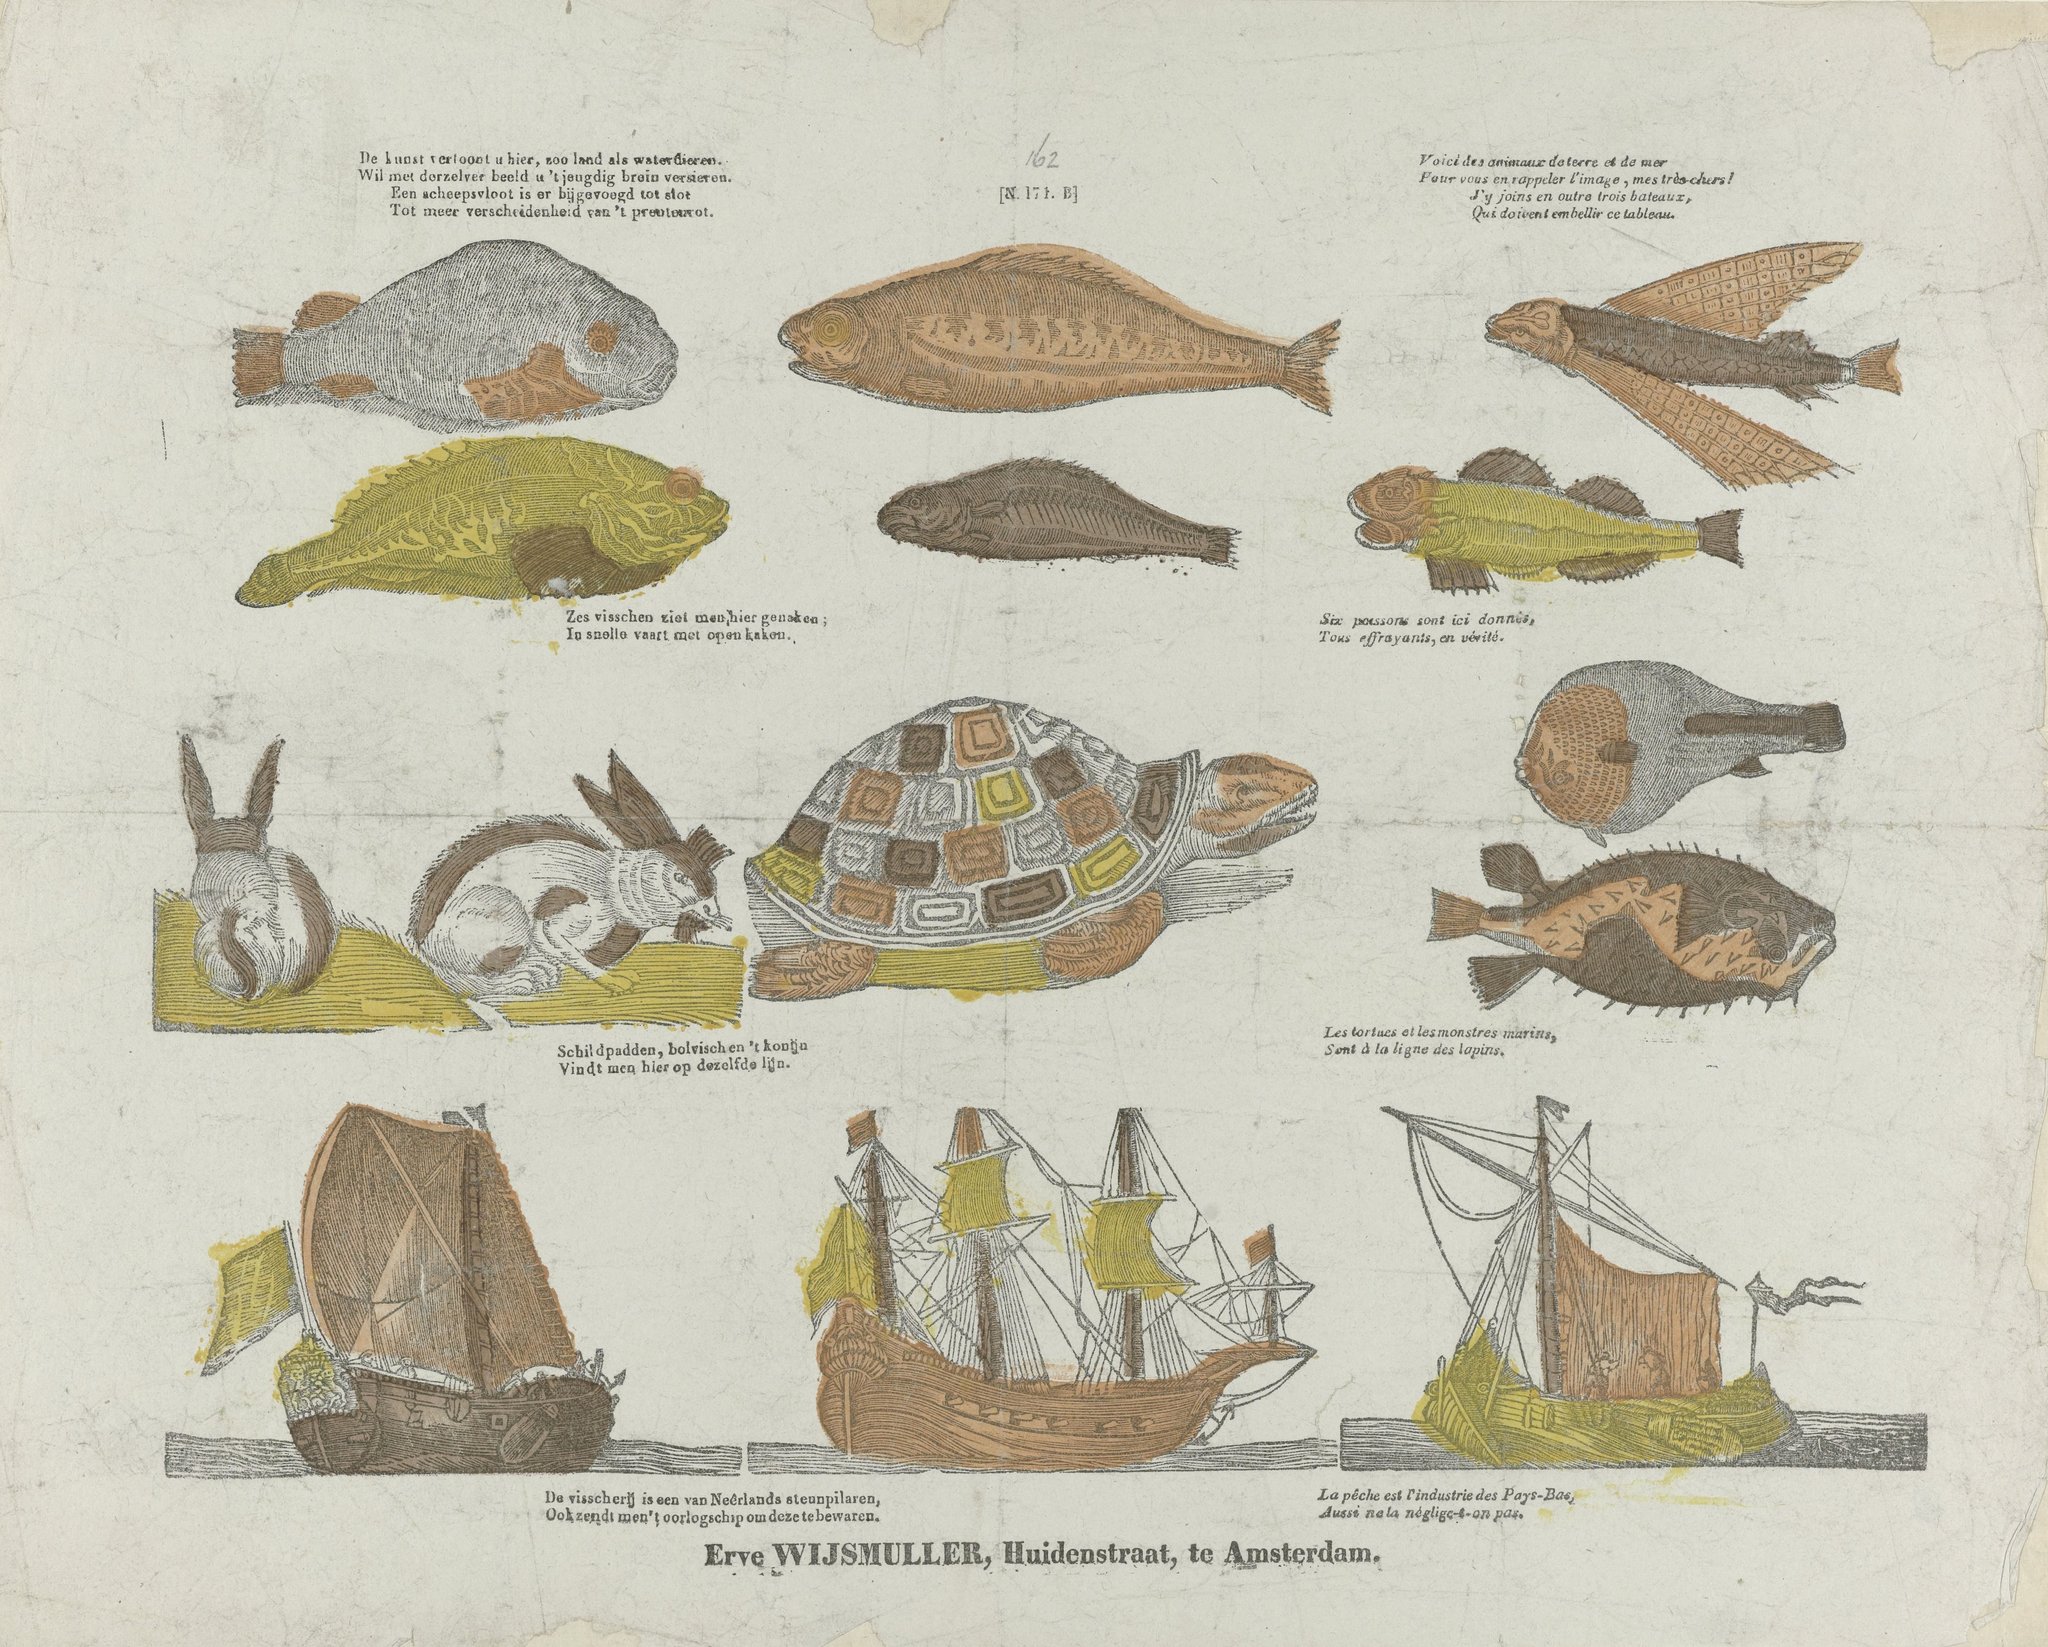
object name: print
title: De kunst vertoont u hier, zoo land als waterdieren / Wil derzelver beeld u 't jeugdig brein versieren [(...)]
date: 1828-1913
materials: paper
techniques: colour, letterpress printing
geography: amsterdam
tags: fishes, ships (in general), rodents: rabbit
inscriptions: collector's mark: Lugt 2760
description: Blad met 3 horizontale rijen met in totaal 9 voorstellingen van vissen, schepen en konijnen. Onder elke rij een tweeregelig vers in het Nederlands en in het Frans. Genummerd midden boven: [N. 171. B].